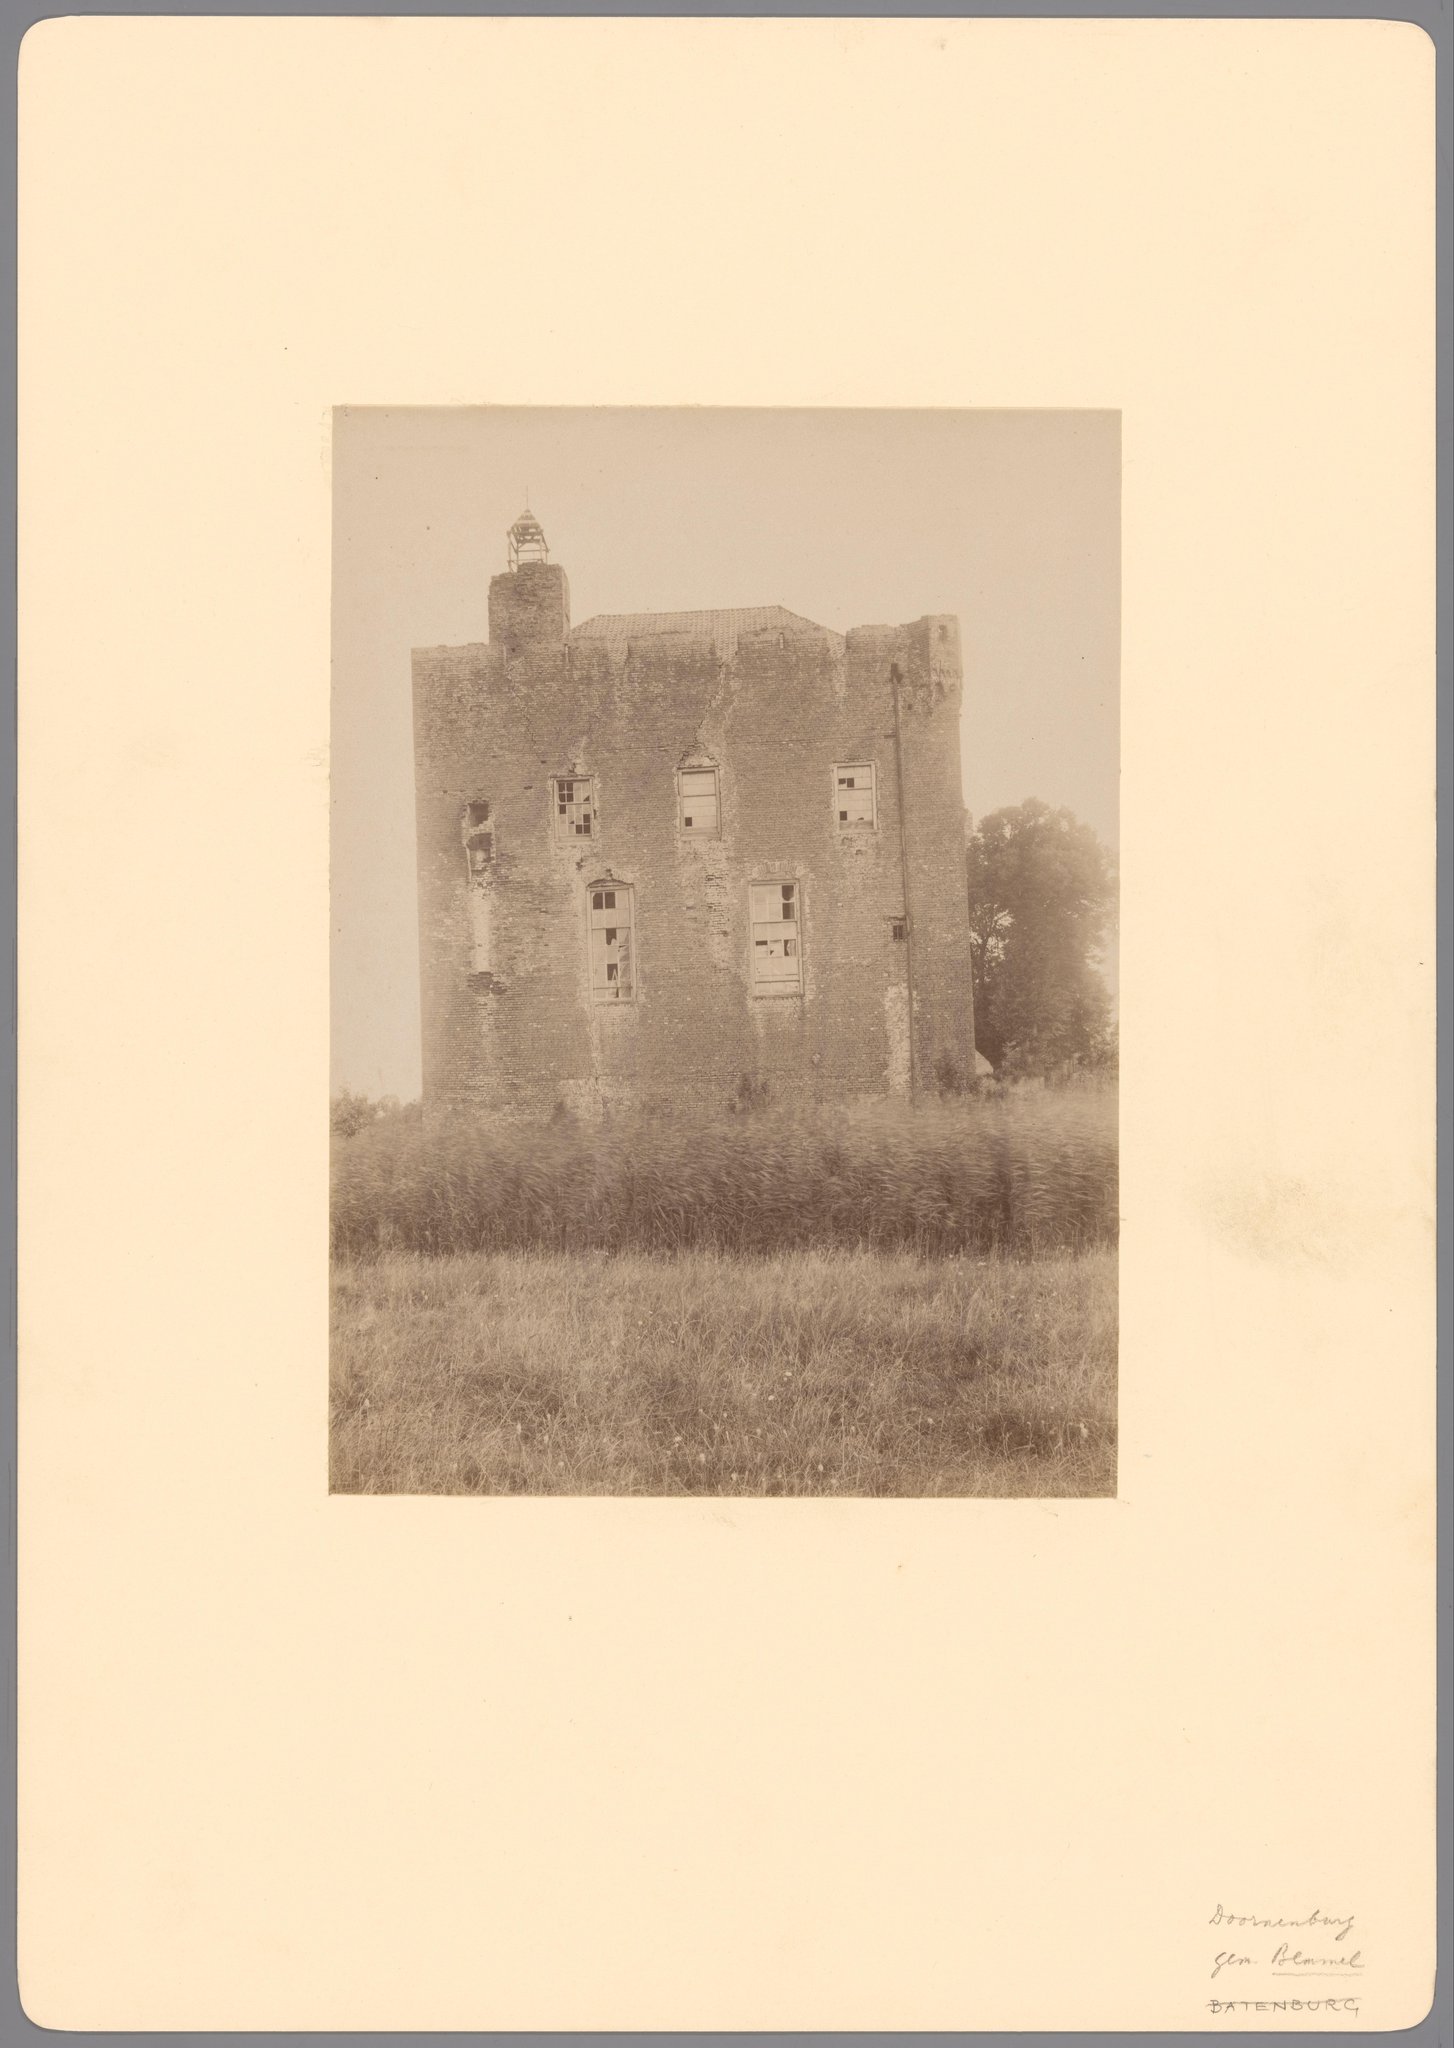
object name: photograph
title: Gezicht op Kasteel Doornenburg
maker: anoniem (monumentenzorg)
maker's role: fotograaf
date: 1903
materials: cardboard, photographic support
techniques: albumen print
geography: doornenburg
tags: castle, landscape with tower or castle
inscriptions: annotation: ‘Doornenburg/ gem. Bemmel’, annotation: ‘Kasteel Batenburg (G.)’